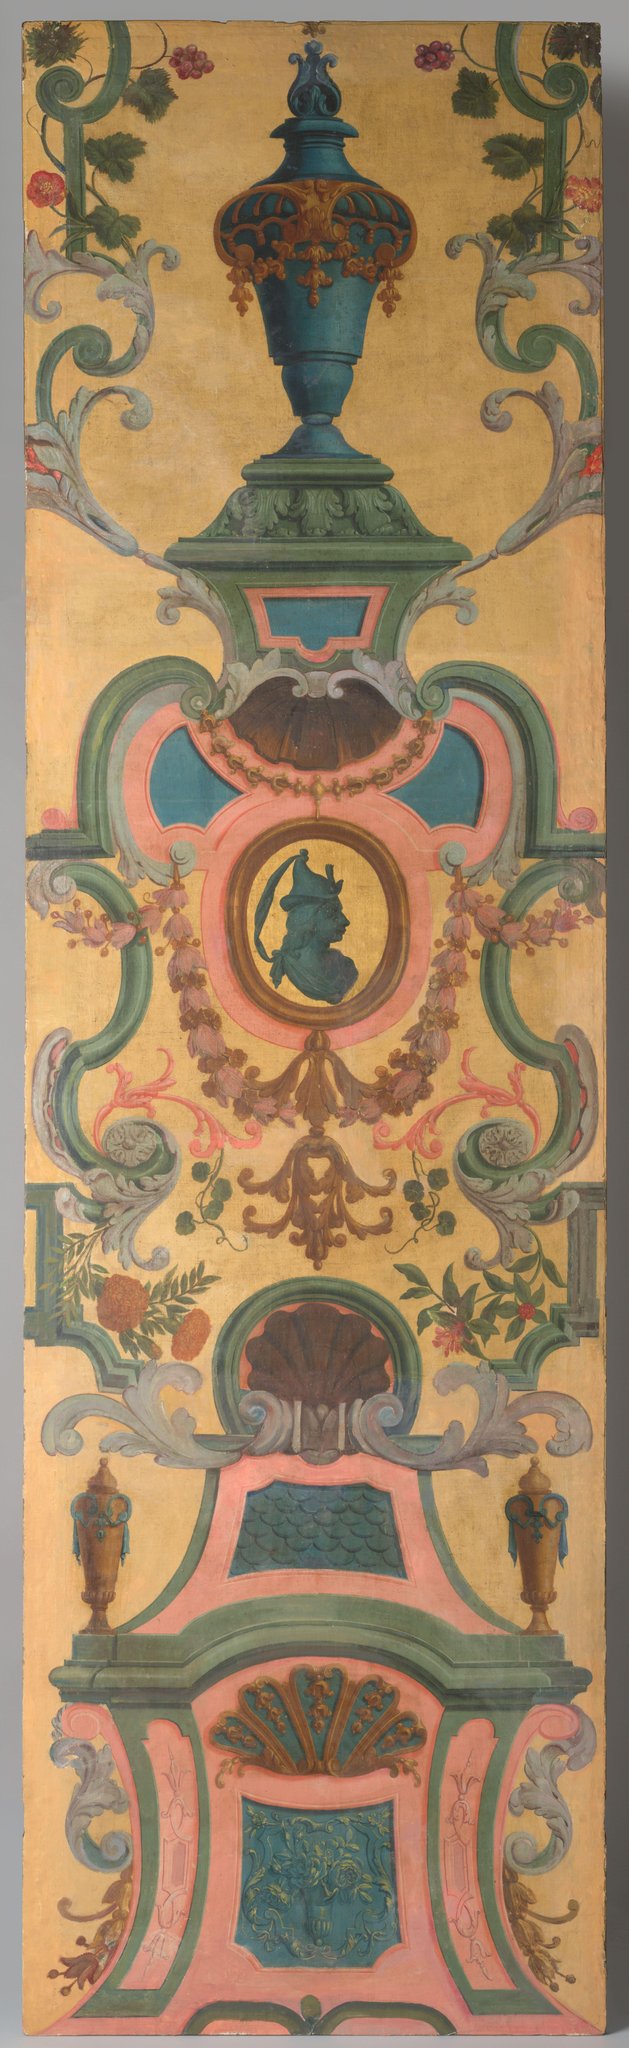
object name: furniture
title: Onderdeel van een kamerscherm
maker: Anonymous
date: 1700-1750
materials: linen, wood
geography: northern netherlands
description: Onderdeel van een kamerscherm van zes slagen, bespannen met beschilderd linnen waarop piedestals, vazen met bloemen, medaillons en vogels in diverse kleuren zijn aangebracht.